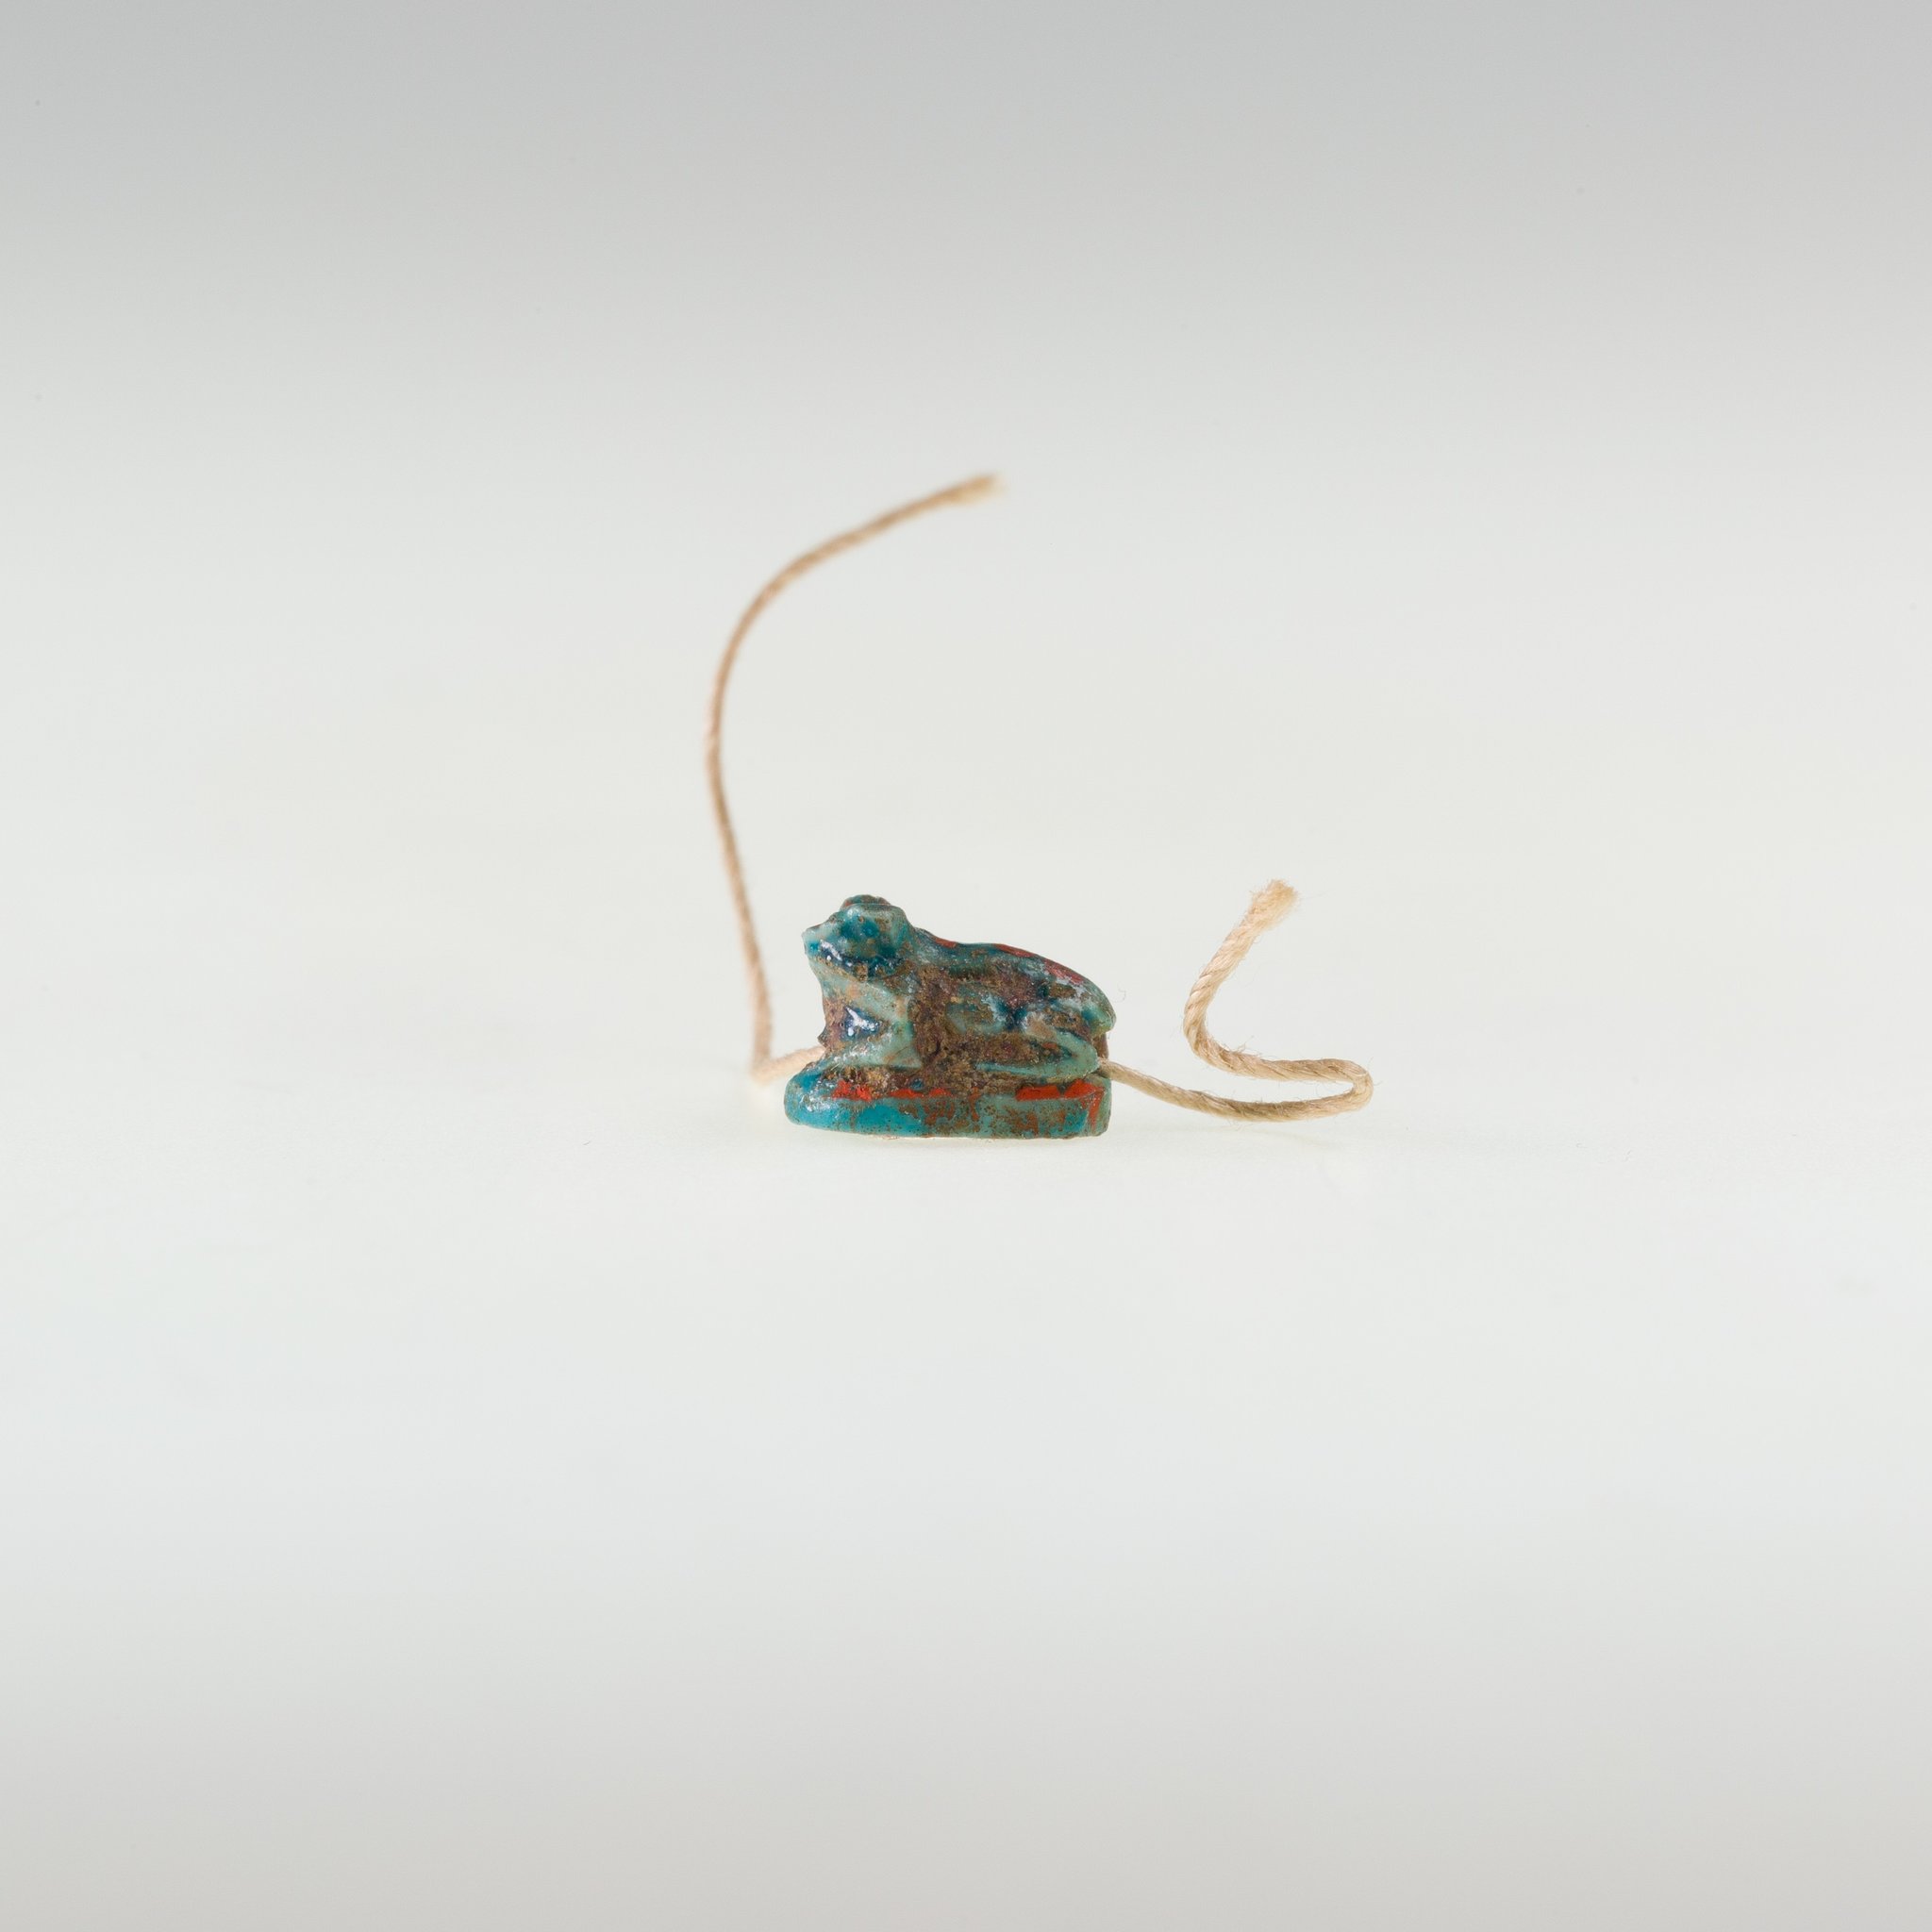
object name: scaraboid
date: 1981-1295 BCE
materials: stone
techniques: glazing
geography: egypt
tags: frogs,scarabs